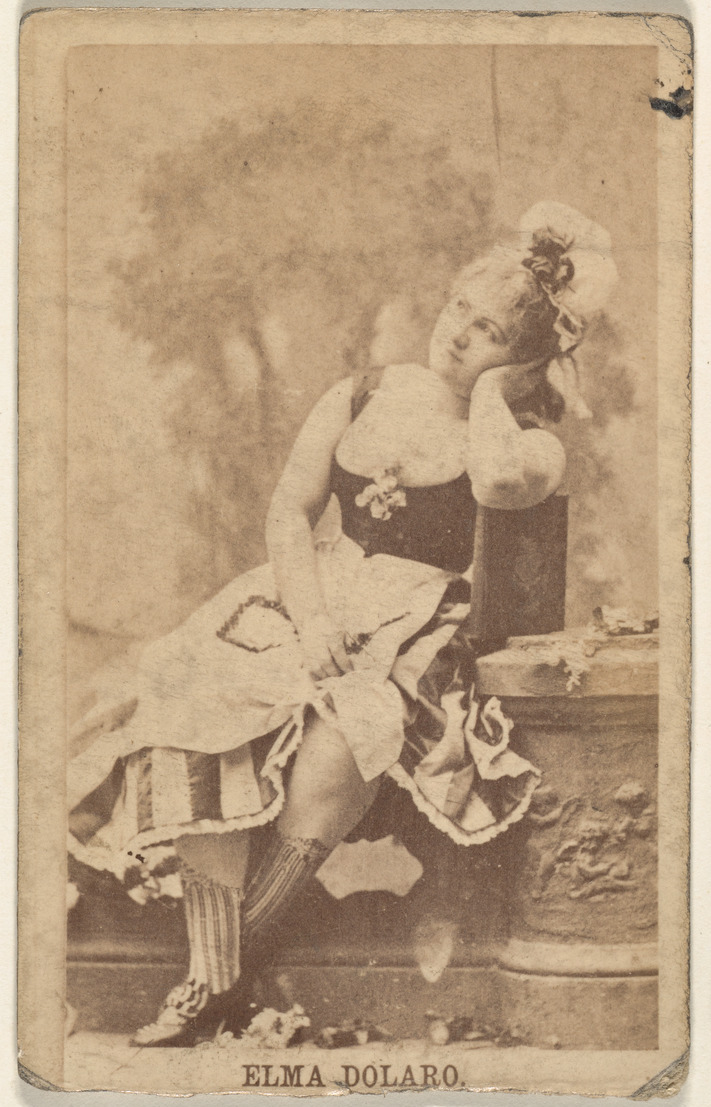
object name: photograph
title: Elma Dolaro, from the Actresses series (N668)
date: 1888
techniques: albumen silver print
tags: portraits,women,actresses